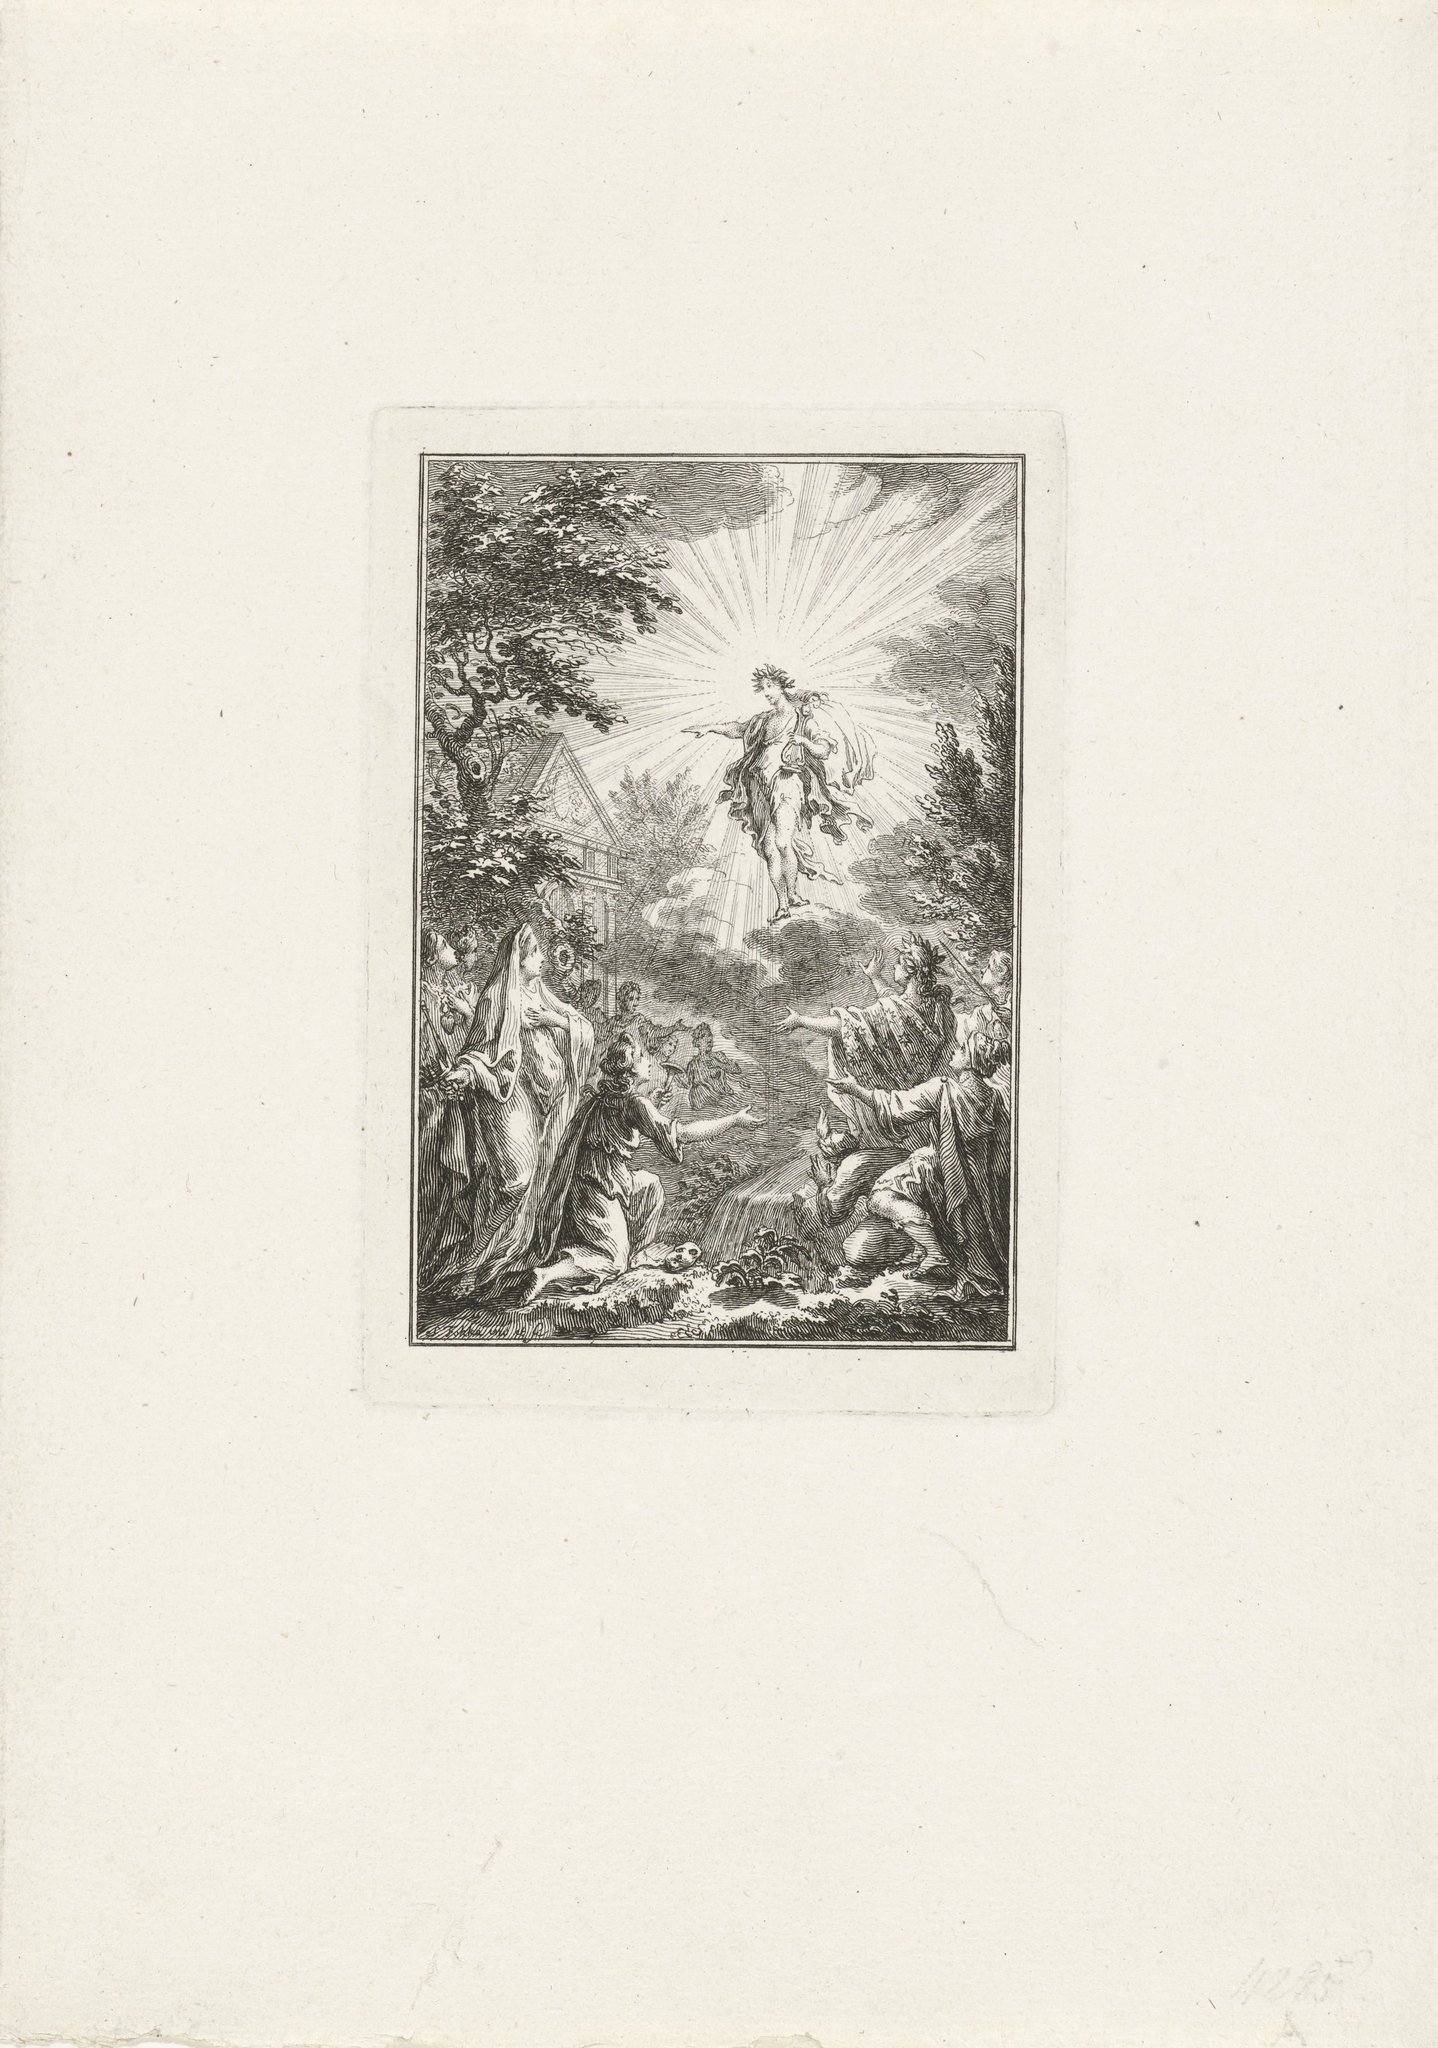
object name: print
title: Allegorie op de nieuwe Schouwburg te Amsterdam, 1774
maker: simon fokke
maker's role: draughtsman, print maker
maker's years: 1712-1784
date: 1774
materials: paper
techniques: etching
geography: northern netherlands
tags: symbolic representations, allegories and emblems ~ the theatre, apollo playing the lyre, apollo citharoedus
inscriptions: collector's mark: Lugt 2228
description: Allegorie op de inwijding van de nieuwe Schouwburg aan het Leidseplein te Amsterdam, 15 september 1774. Apollo verschijnt in zonnestralen en wijst enkele vrouwelijke personificaties, gerelateerd aan het toneel, op het nieuwe gebouw.